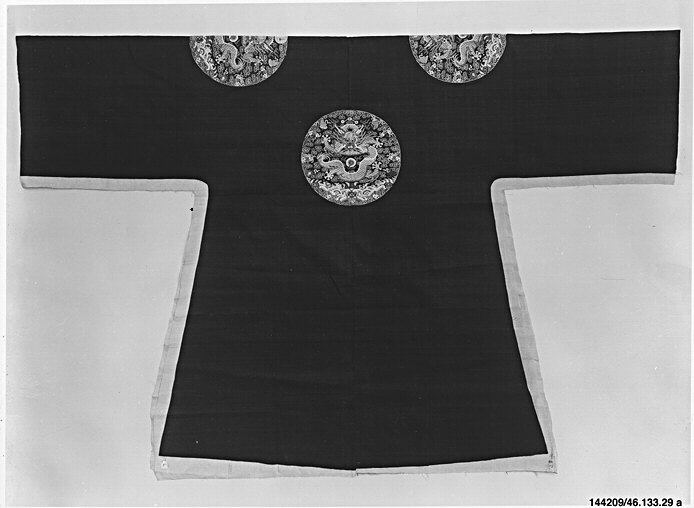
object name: coat, emperor's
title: Emperor's Coat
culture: chinese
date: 1867-1900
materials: metal thread, silk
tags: dragons